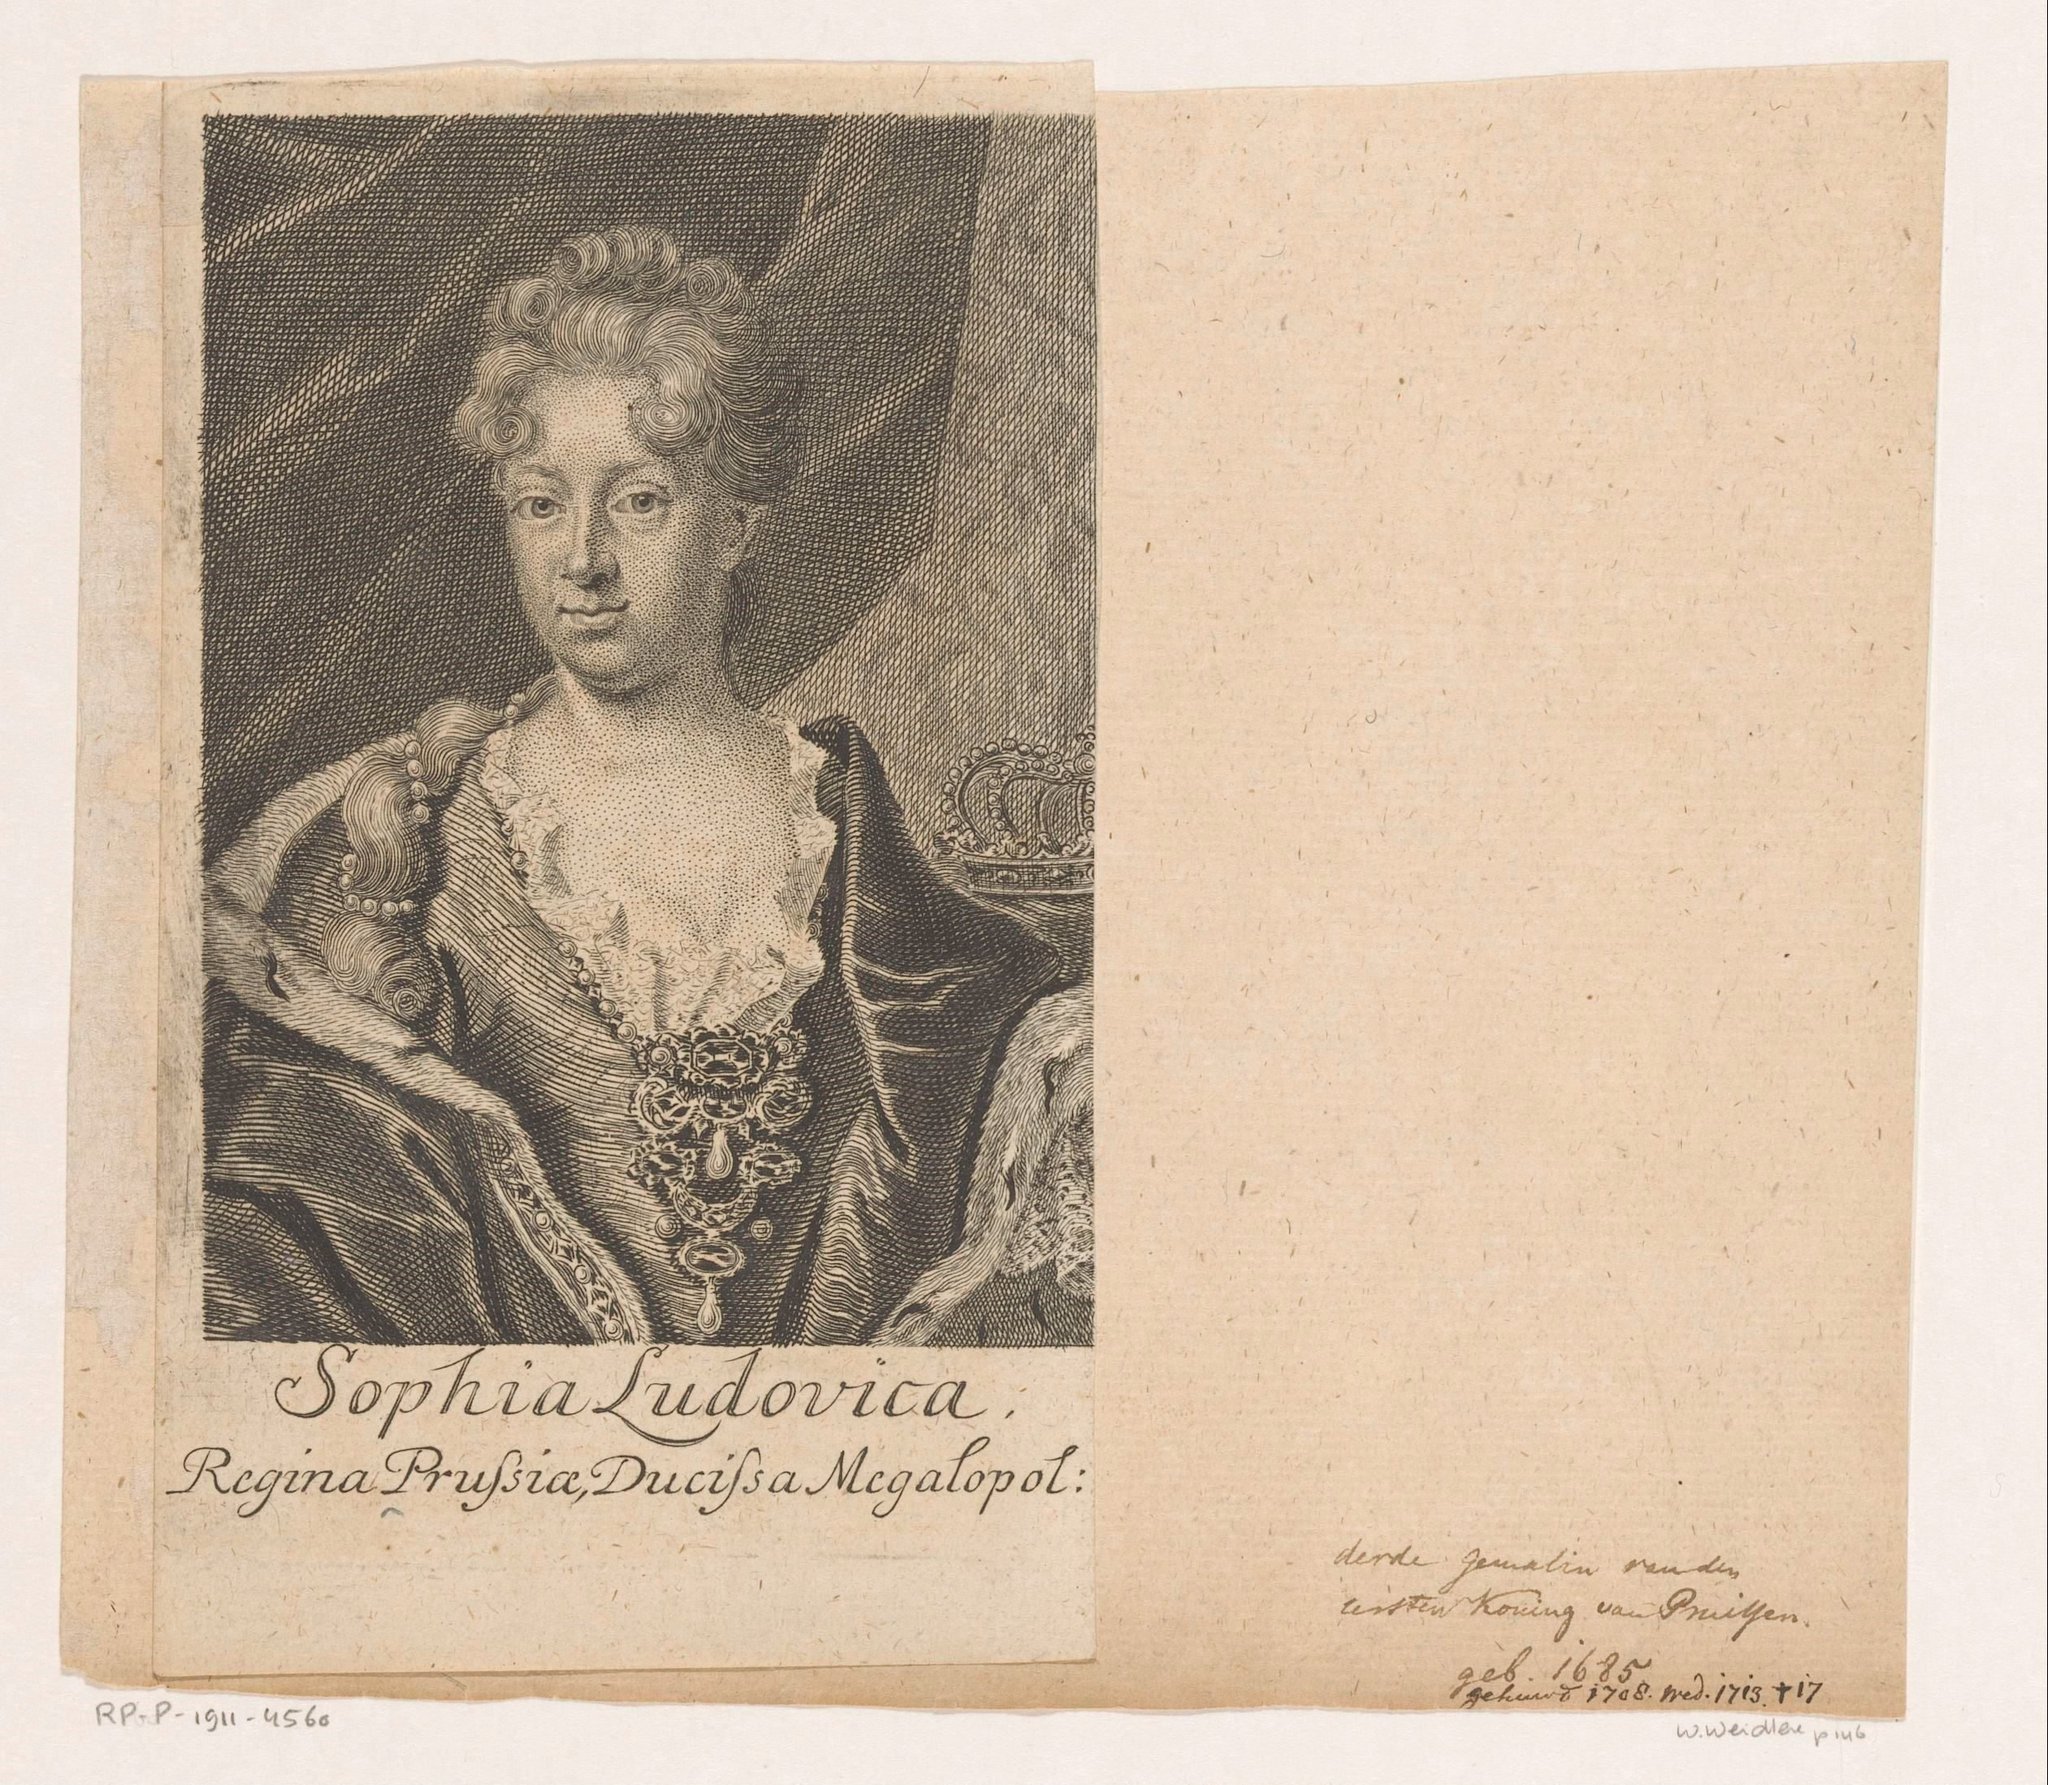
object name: print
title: Portret van Sophie Luise von Mecklenburg-Schwerin, koningin van Pruisen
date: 1708-1733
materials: paper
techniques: engraving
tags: crown (symbol of sovereignty), historical persons - bb - woman, ornaments, jewels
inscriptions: collector's mark: Lugt 2228